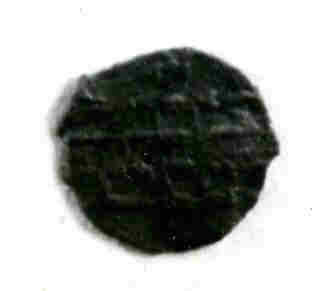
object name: coin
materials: copper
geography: iran